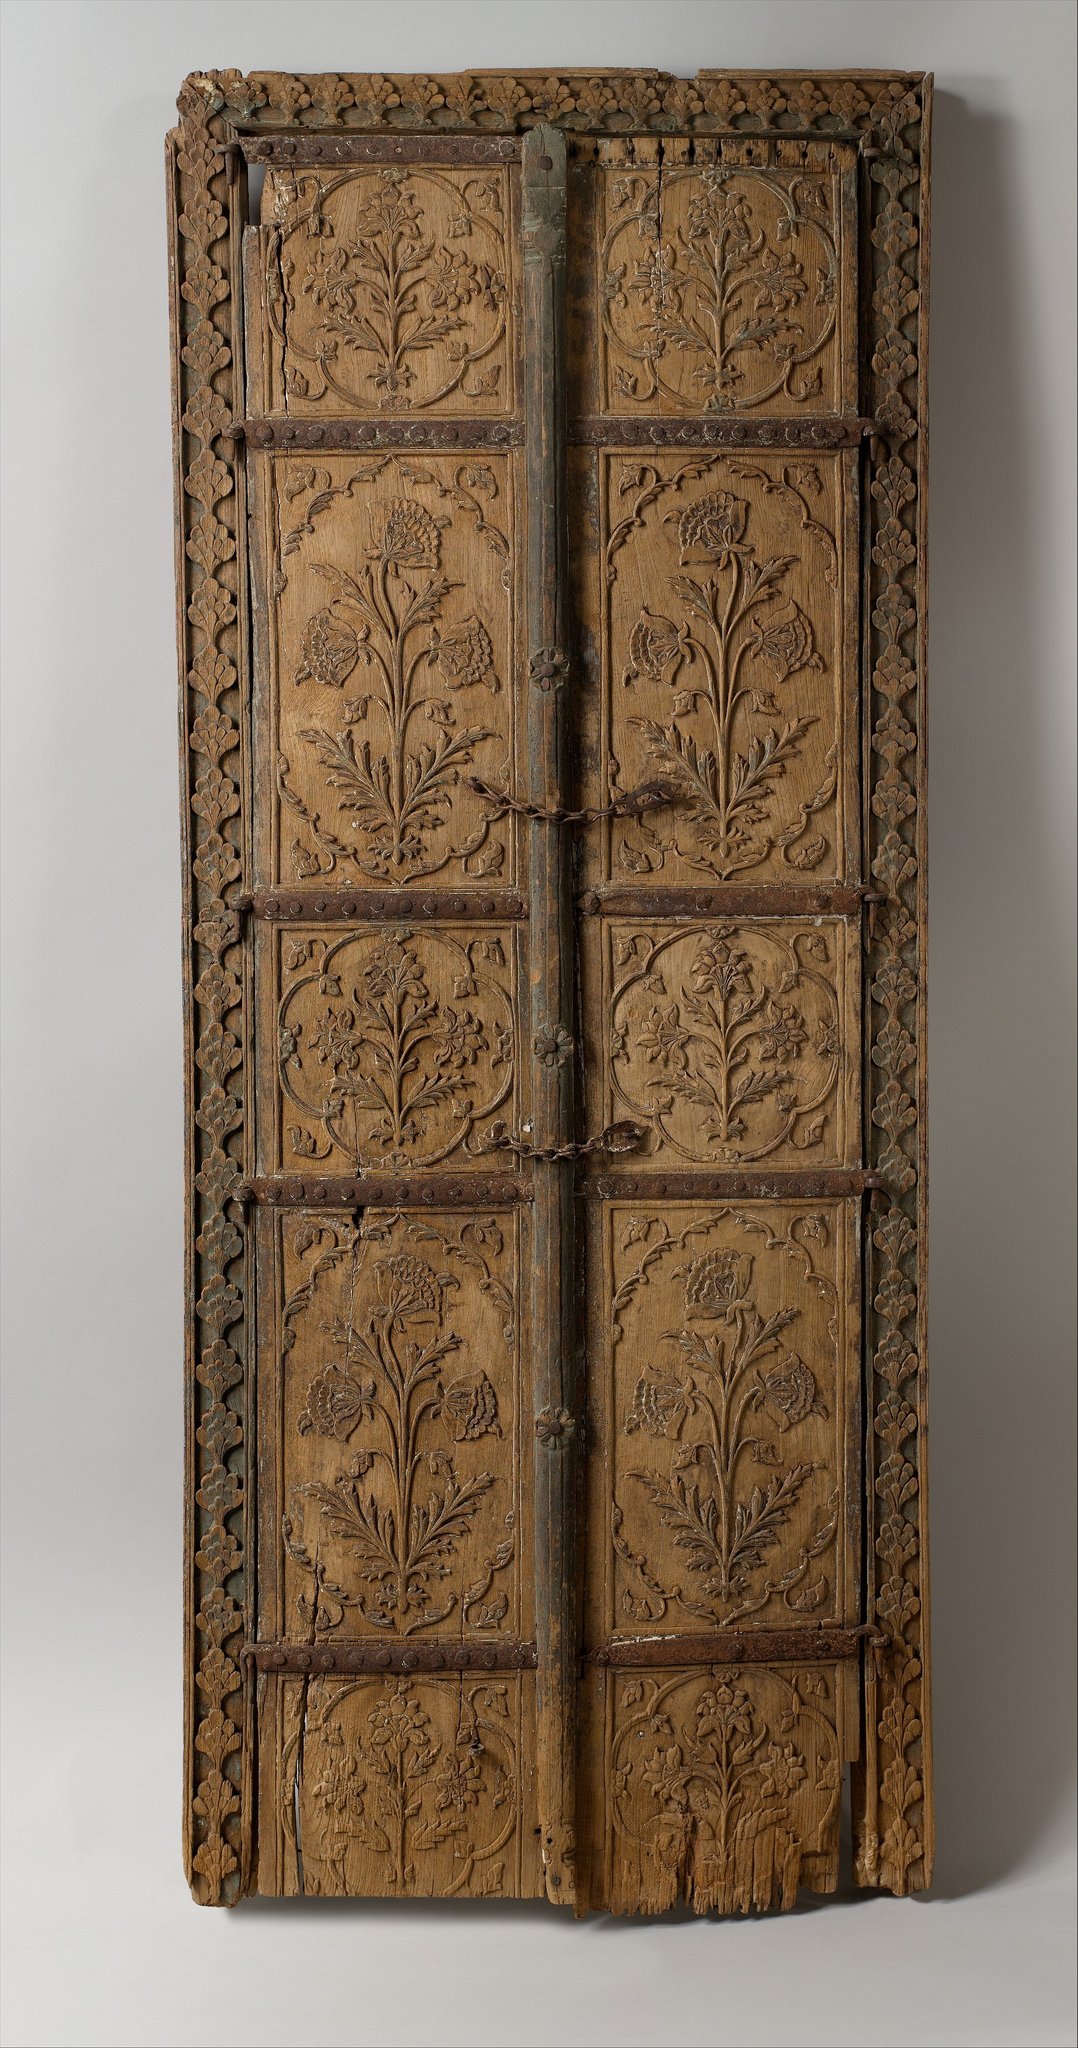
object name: pair of door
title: Pair of Flower Style Doors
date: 1651-1700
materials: paint, wood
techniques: carving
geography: northern india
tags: flowers